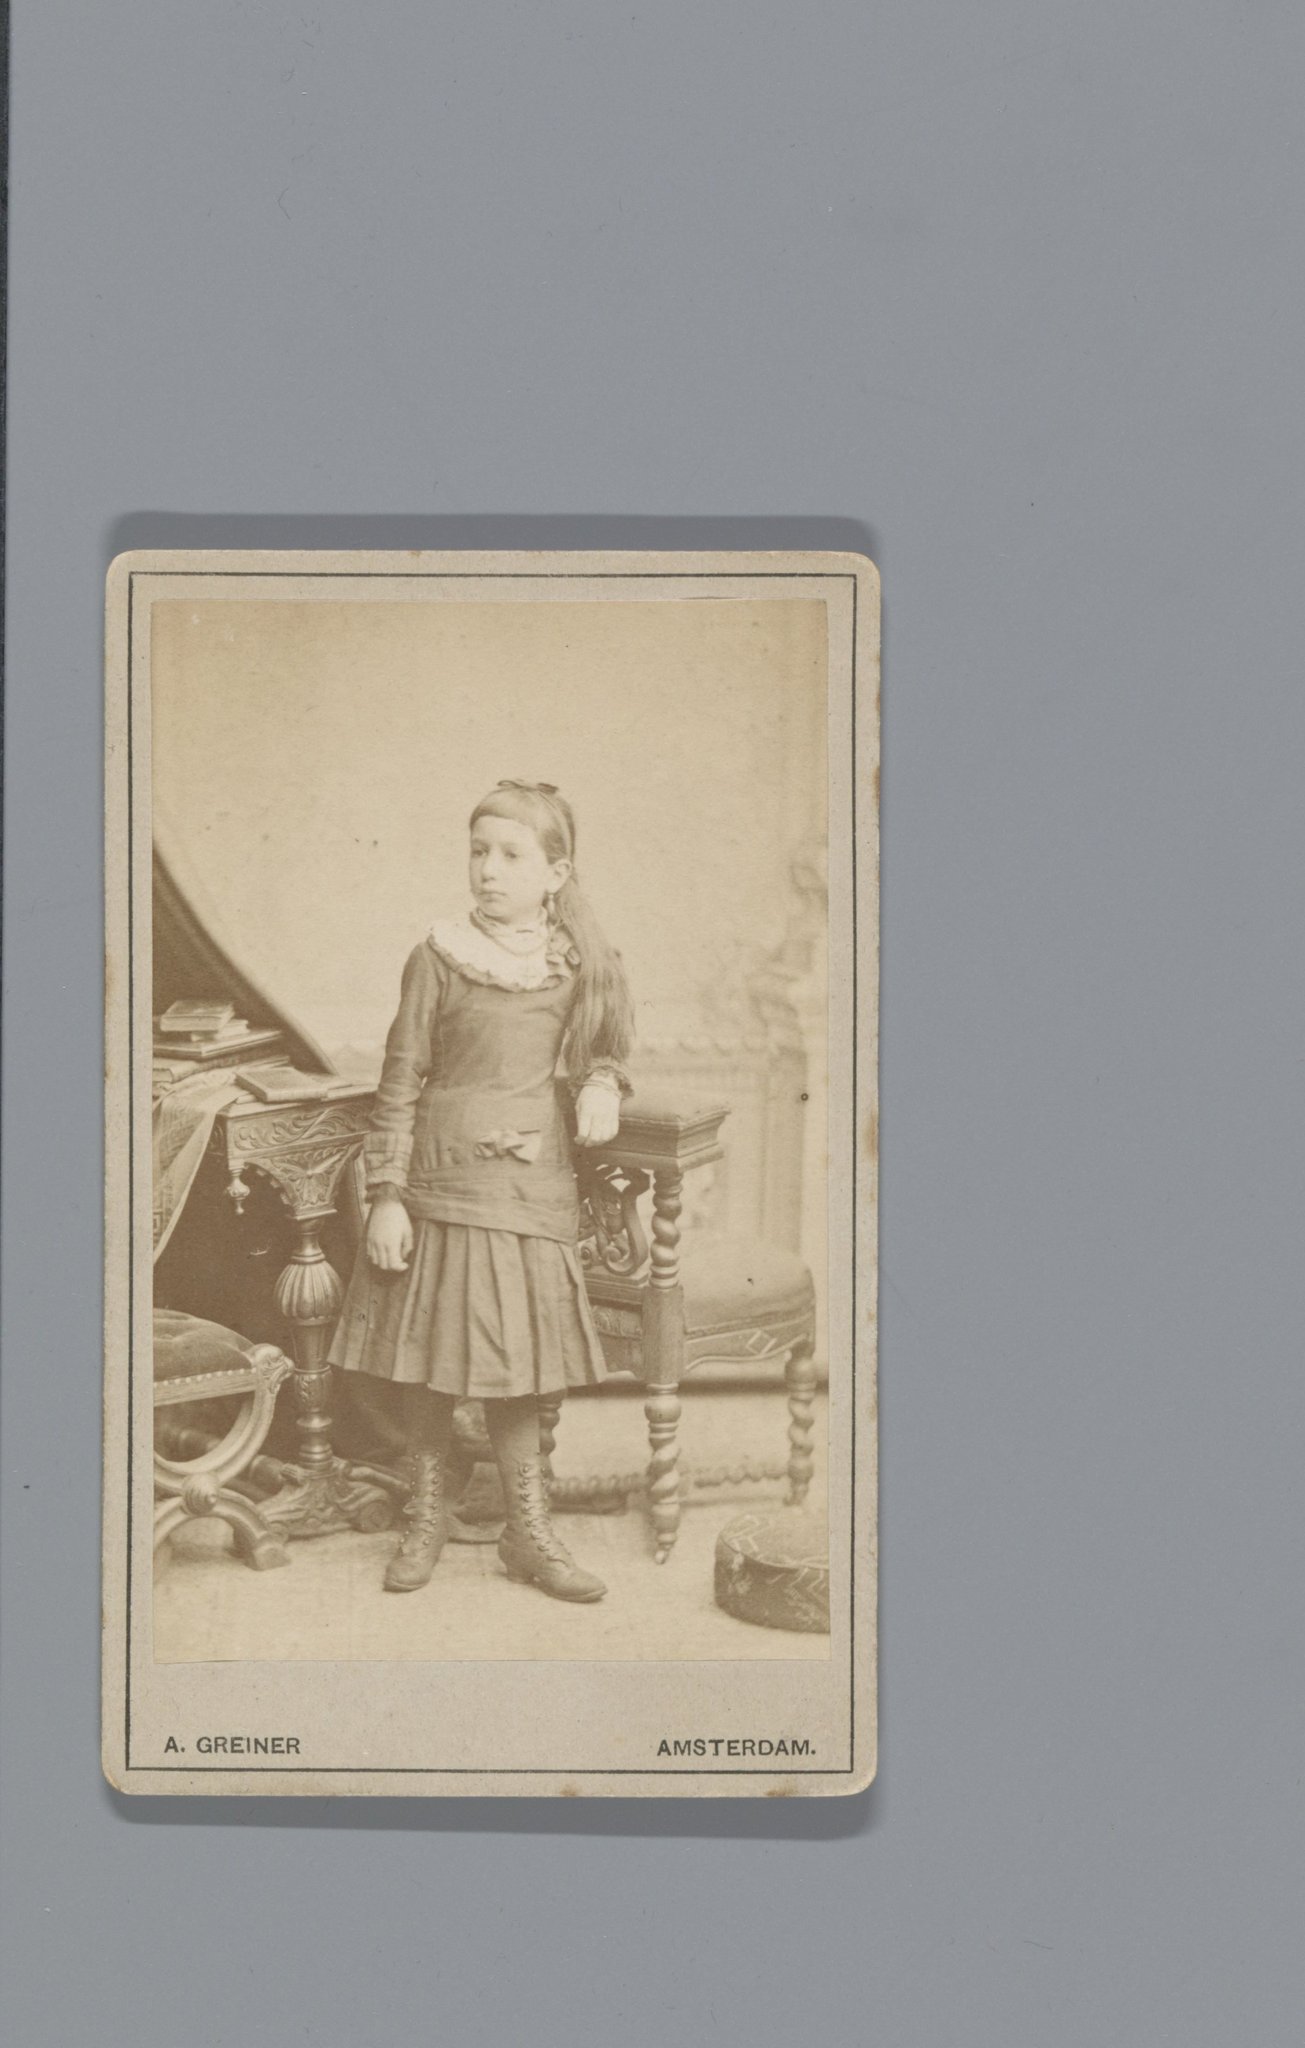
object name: carte de visite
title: Marie Witsen als meisje (Amsterdam)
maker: albert greiner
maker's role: fotograaf, fotostudio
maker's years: 1833-1890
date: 1860-1915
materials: cardboard, paper, photographic support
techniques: albumen print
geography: amsterdam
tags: augusta maria agnes witsen-schorr, amsterdam